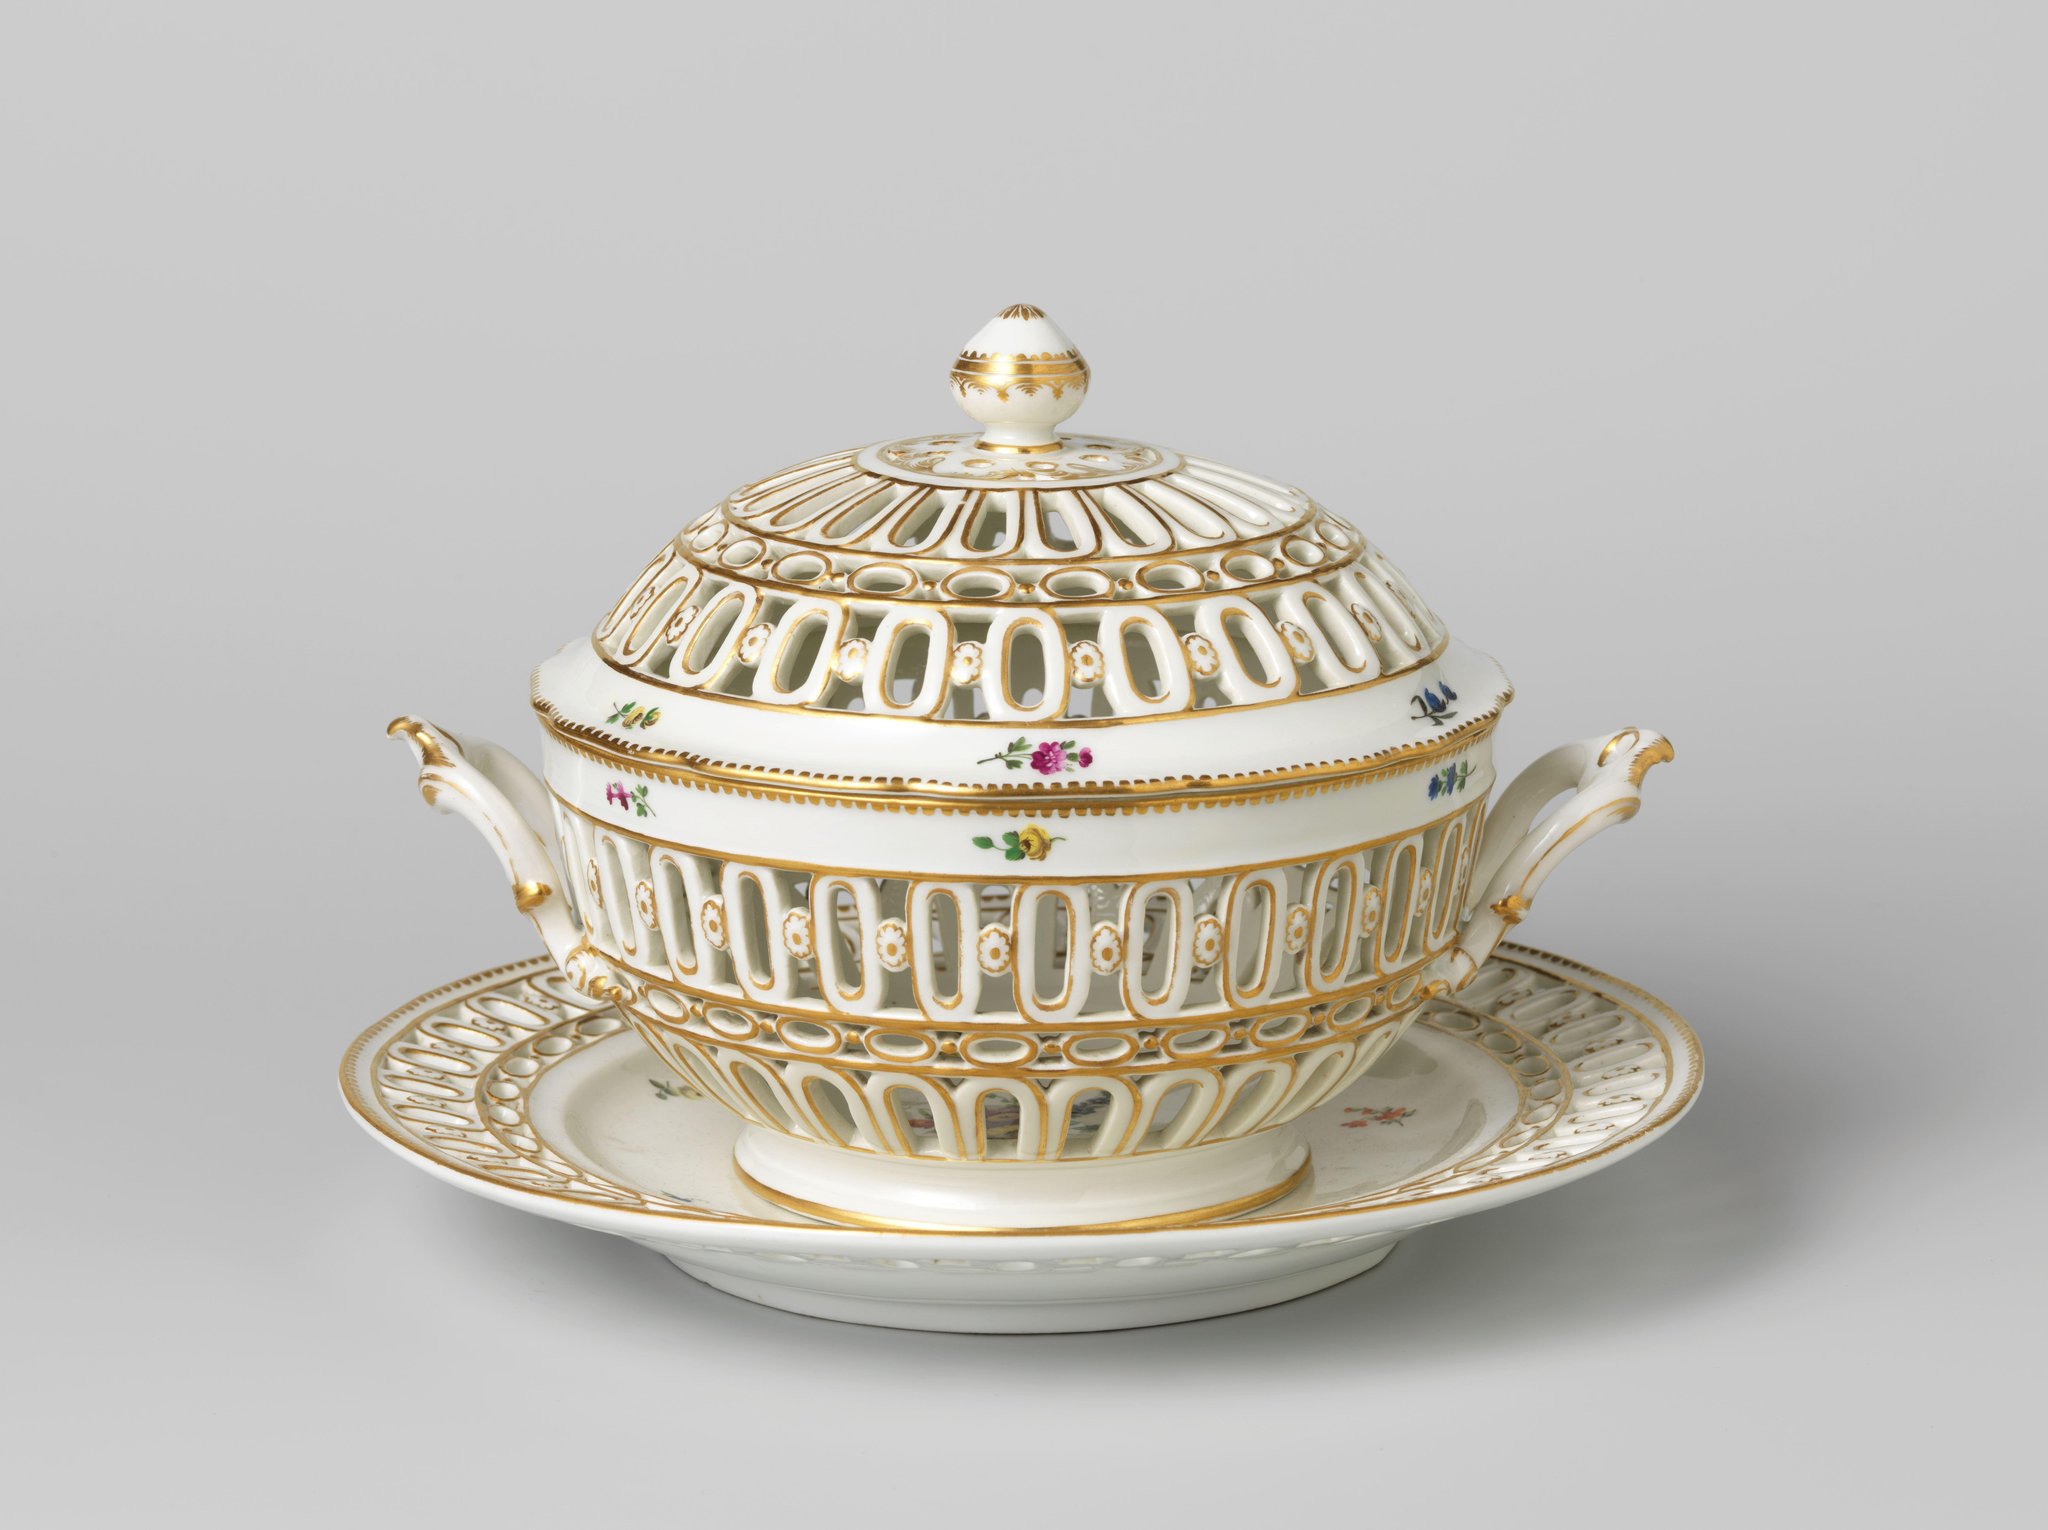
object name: notenmand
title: Notenmand met opengewerkte wanden, beschilderd met strooibloemen en gouden biezen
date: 1782-1784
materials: porcelain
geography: loosdrecht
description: Notenmand van porselein. Met plastisch versierde oren. Mand en deksel zijn opengewerkt. Op de buitenranden veelkleurige strooibloempjes, evenals op de bodem van de mand. In het midden van de bodem een kleurig bloemboeket. Alle randen, ook die van de opengewerkte delen zijn met gouden biezen versierd. Het bovenvlak van het deksel en de knop zijn ook met goud beschilderd, evenals de oren.